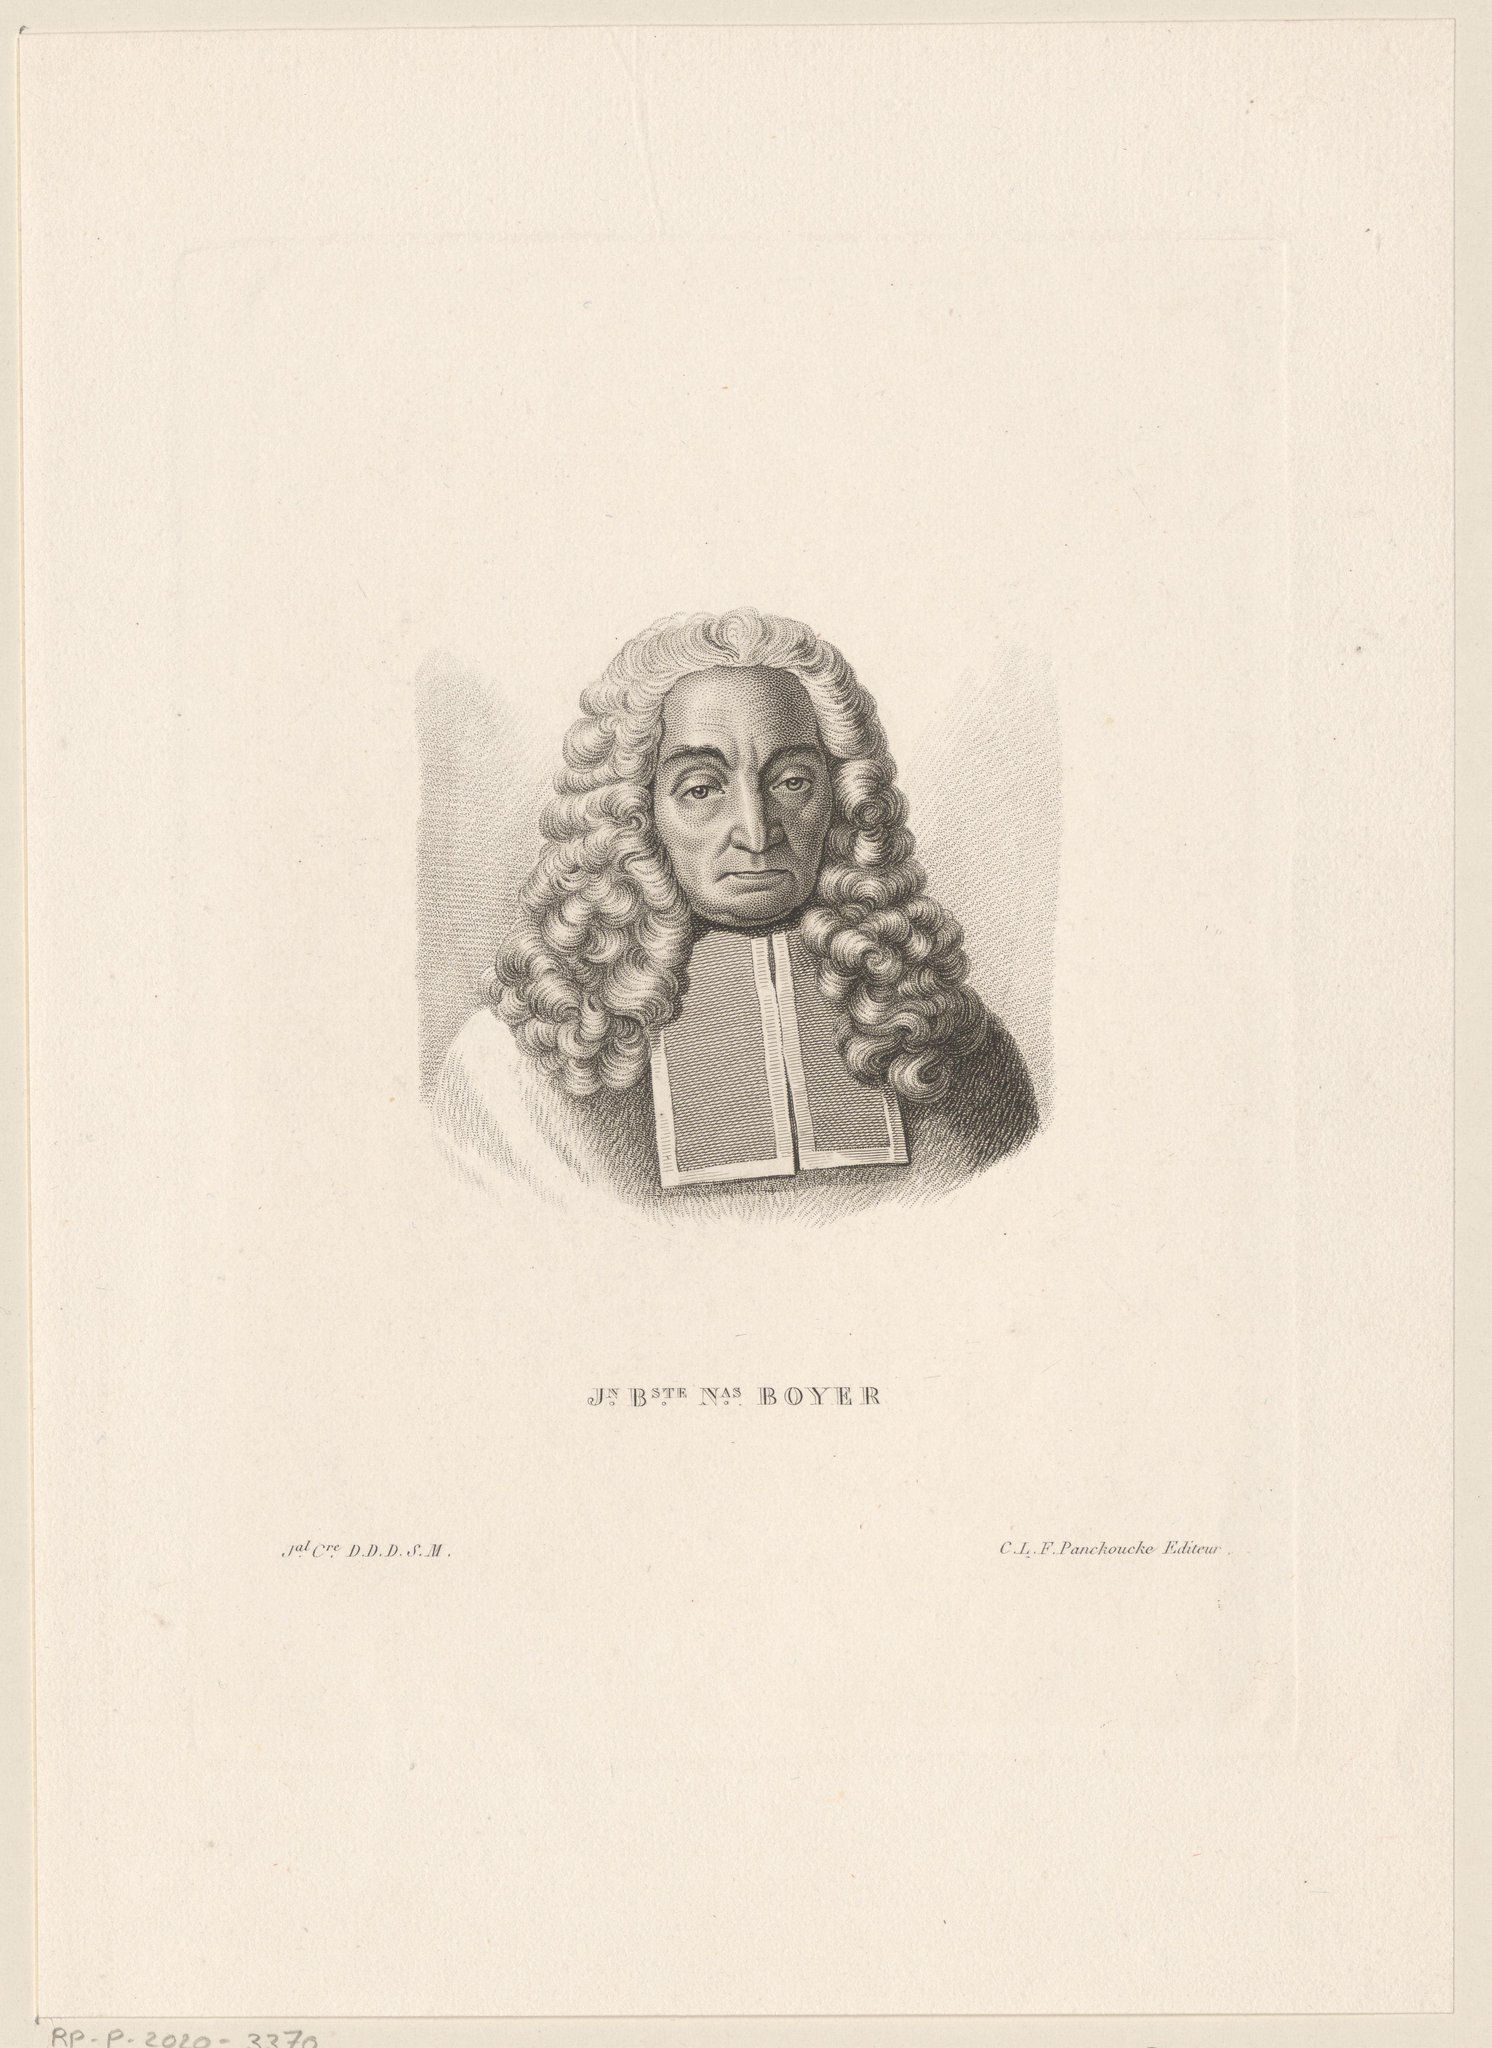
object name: print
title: Portret van Jean-Baptiste-Nicolas Boyer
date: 1825-1840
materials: paper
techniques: etching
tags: paris, historical persons